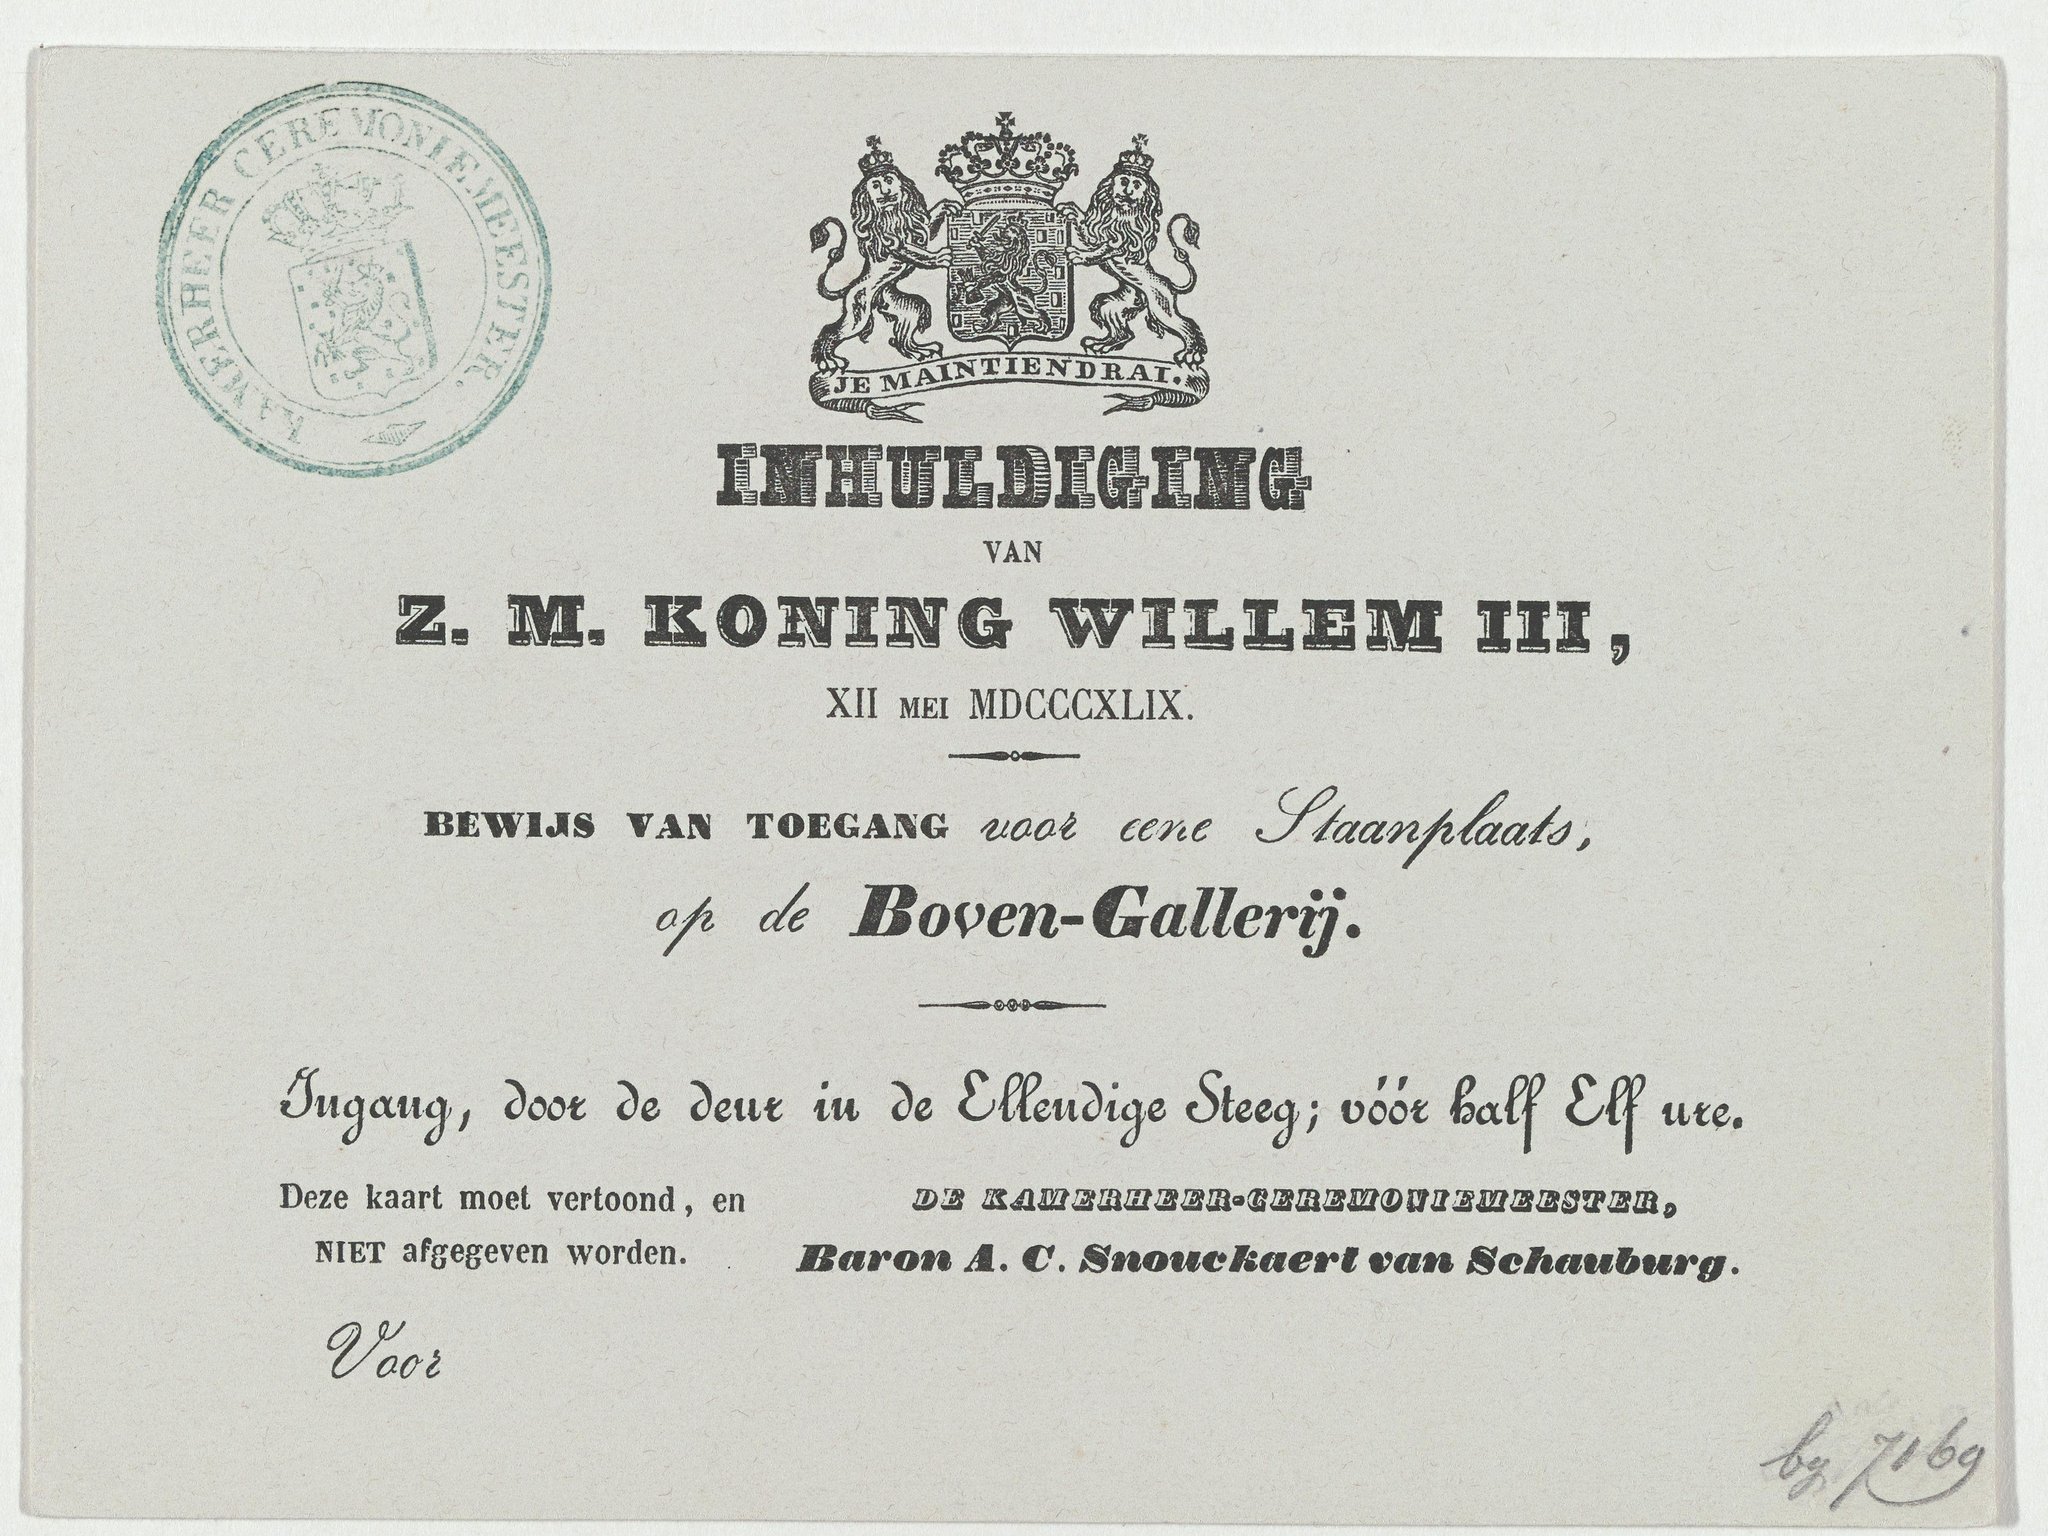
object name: admission ticket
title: Toegangsbewijs voor de inhuldiging van koning Willem III, 1849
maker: Anonymous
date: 1805-1849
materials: paper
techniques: letterpress printing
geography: netherlands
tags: brussels, willem iii (koning der nederlanden), installation of a ruler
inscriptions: collector's mark: Lugt 2228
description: Toegangsbewijs voor de inhuldiging van koning Willem III in de Nieuwe Kerk te Amsterdam op 12 mei 1849. Bewijs van toegang voor een staanplaats op de boven-gallerij. Met de stempel van de kamerheer ceremoniemeester. Zonder naam.